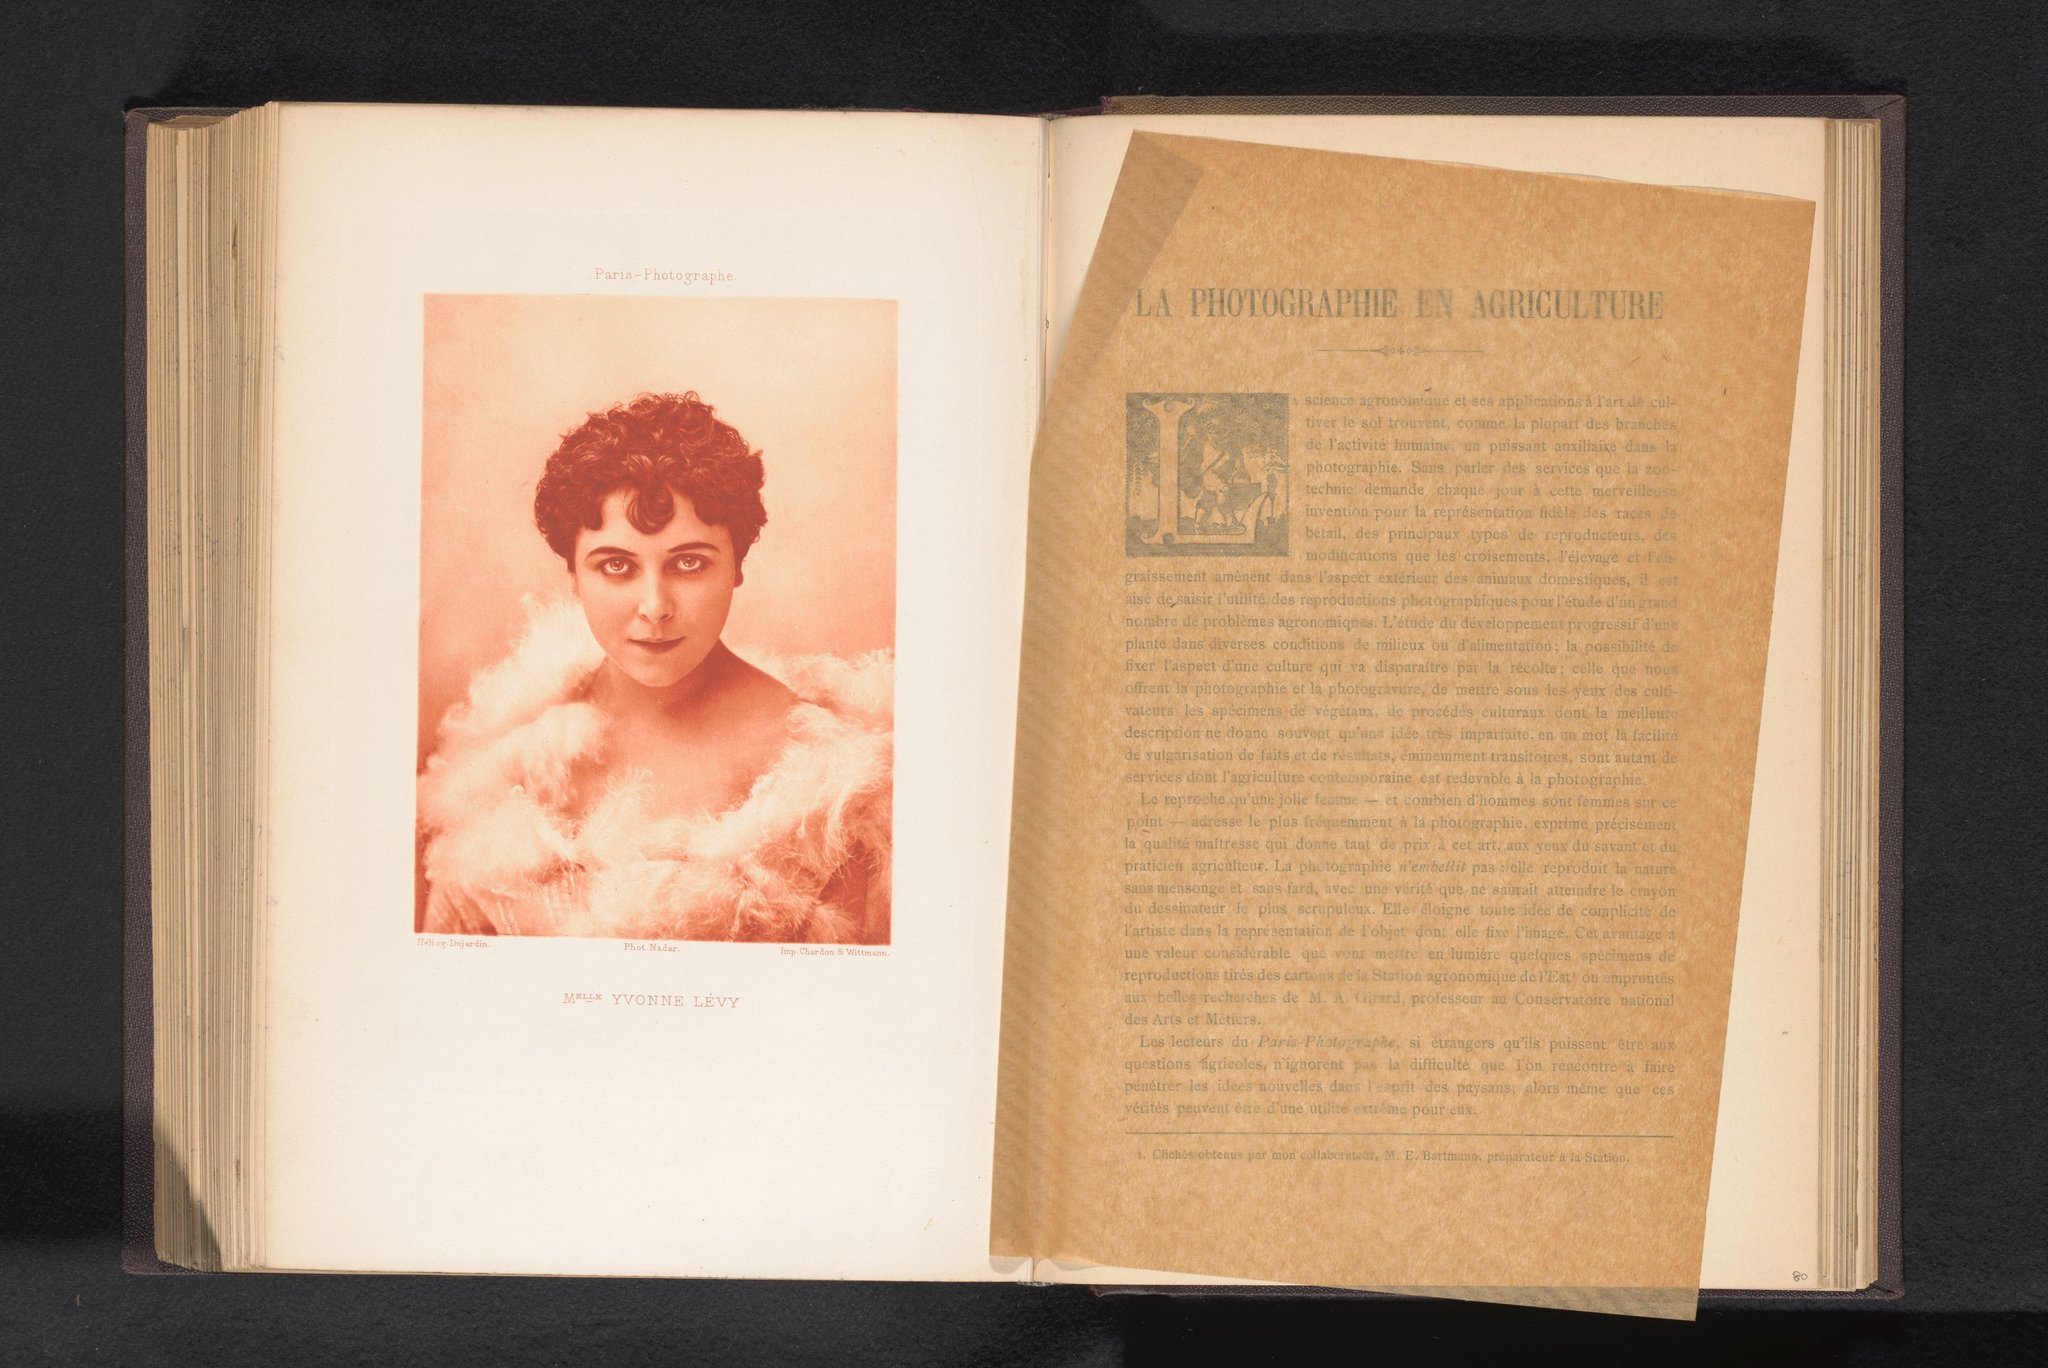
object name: photomechanical print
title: Portret van Yvonne Lévy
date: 1882-1892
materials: paper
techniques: photoaquatint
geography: paris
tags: portrait of actor, actress